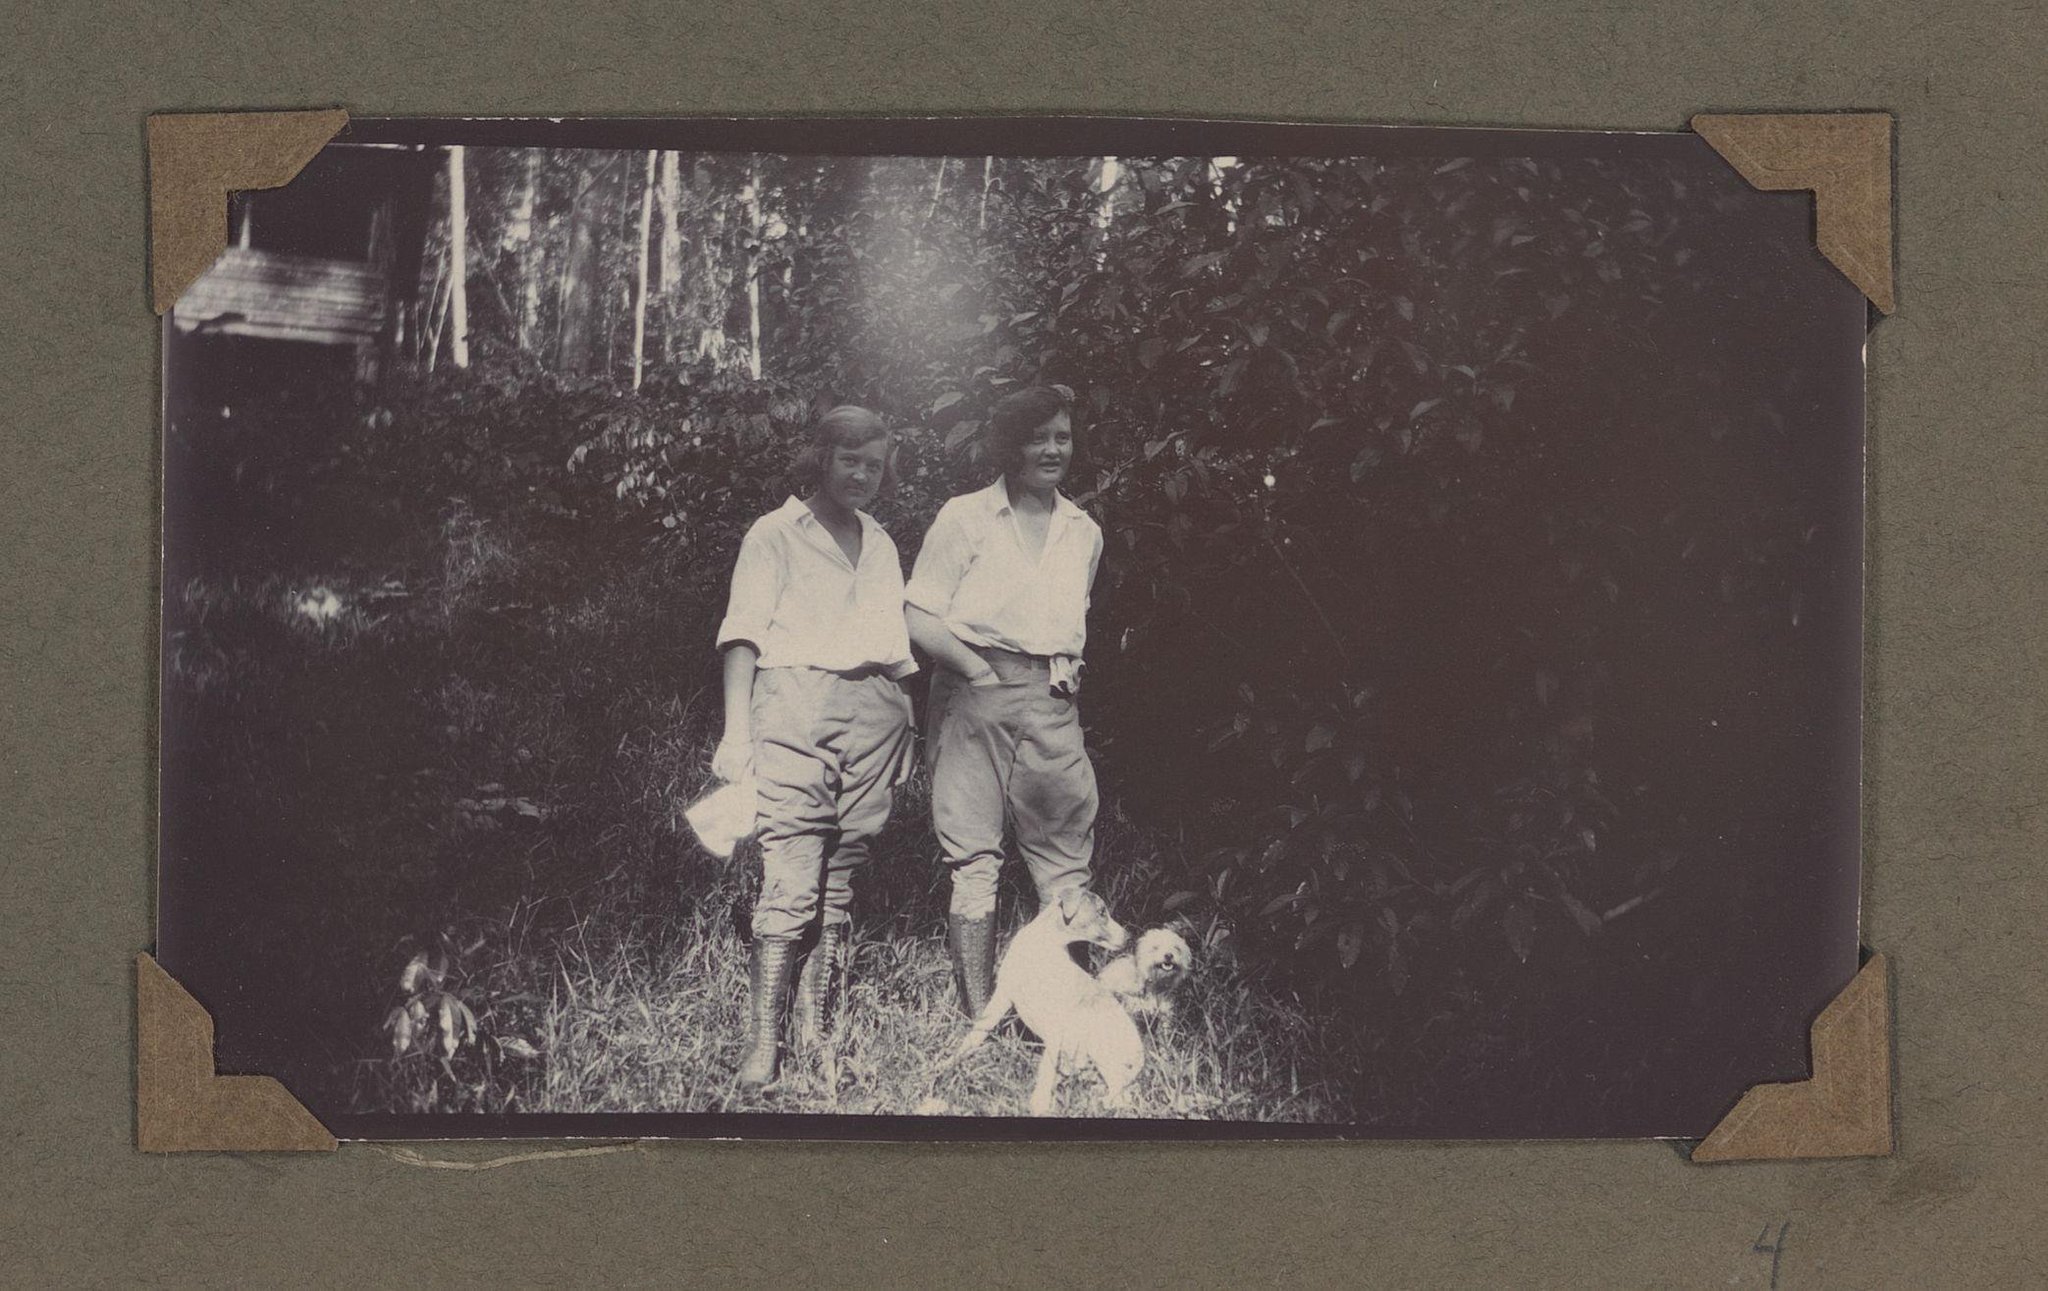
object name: photograph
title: Edith Jetten en een vrouw bij struikgewas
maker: Anonymous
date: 1925-1927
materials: photographic support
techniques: photography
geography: suriname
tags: jetten, familie, moengo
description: Edith Jetten en een andere vrouw staande bij struikgewas, met twee hondjes. Foto op een bladzijde van een los albumblad. Onderdeel van het ensemble met foto's van de familie van ingenieur Jetten in de mijnbouwstad Moengo in Suriname.